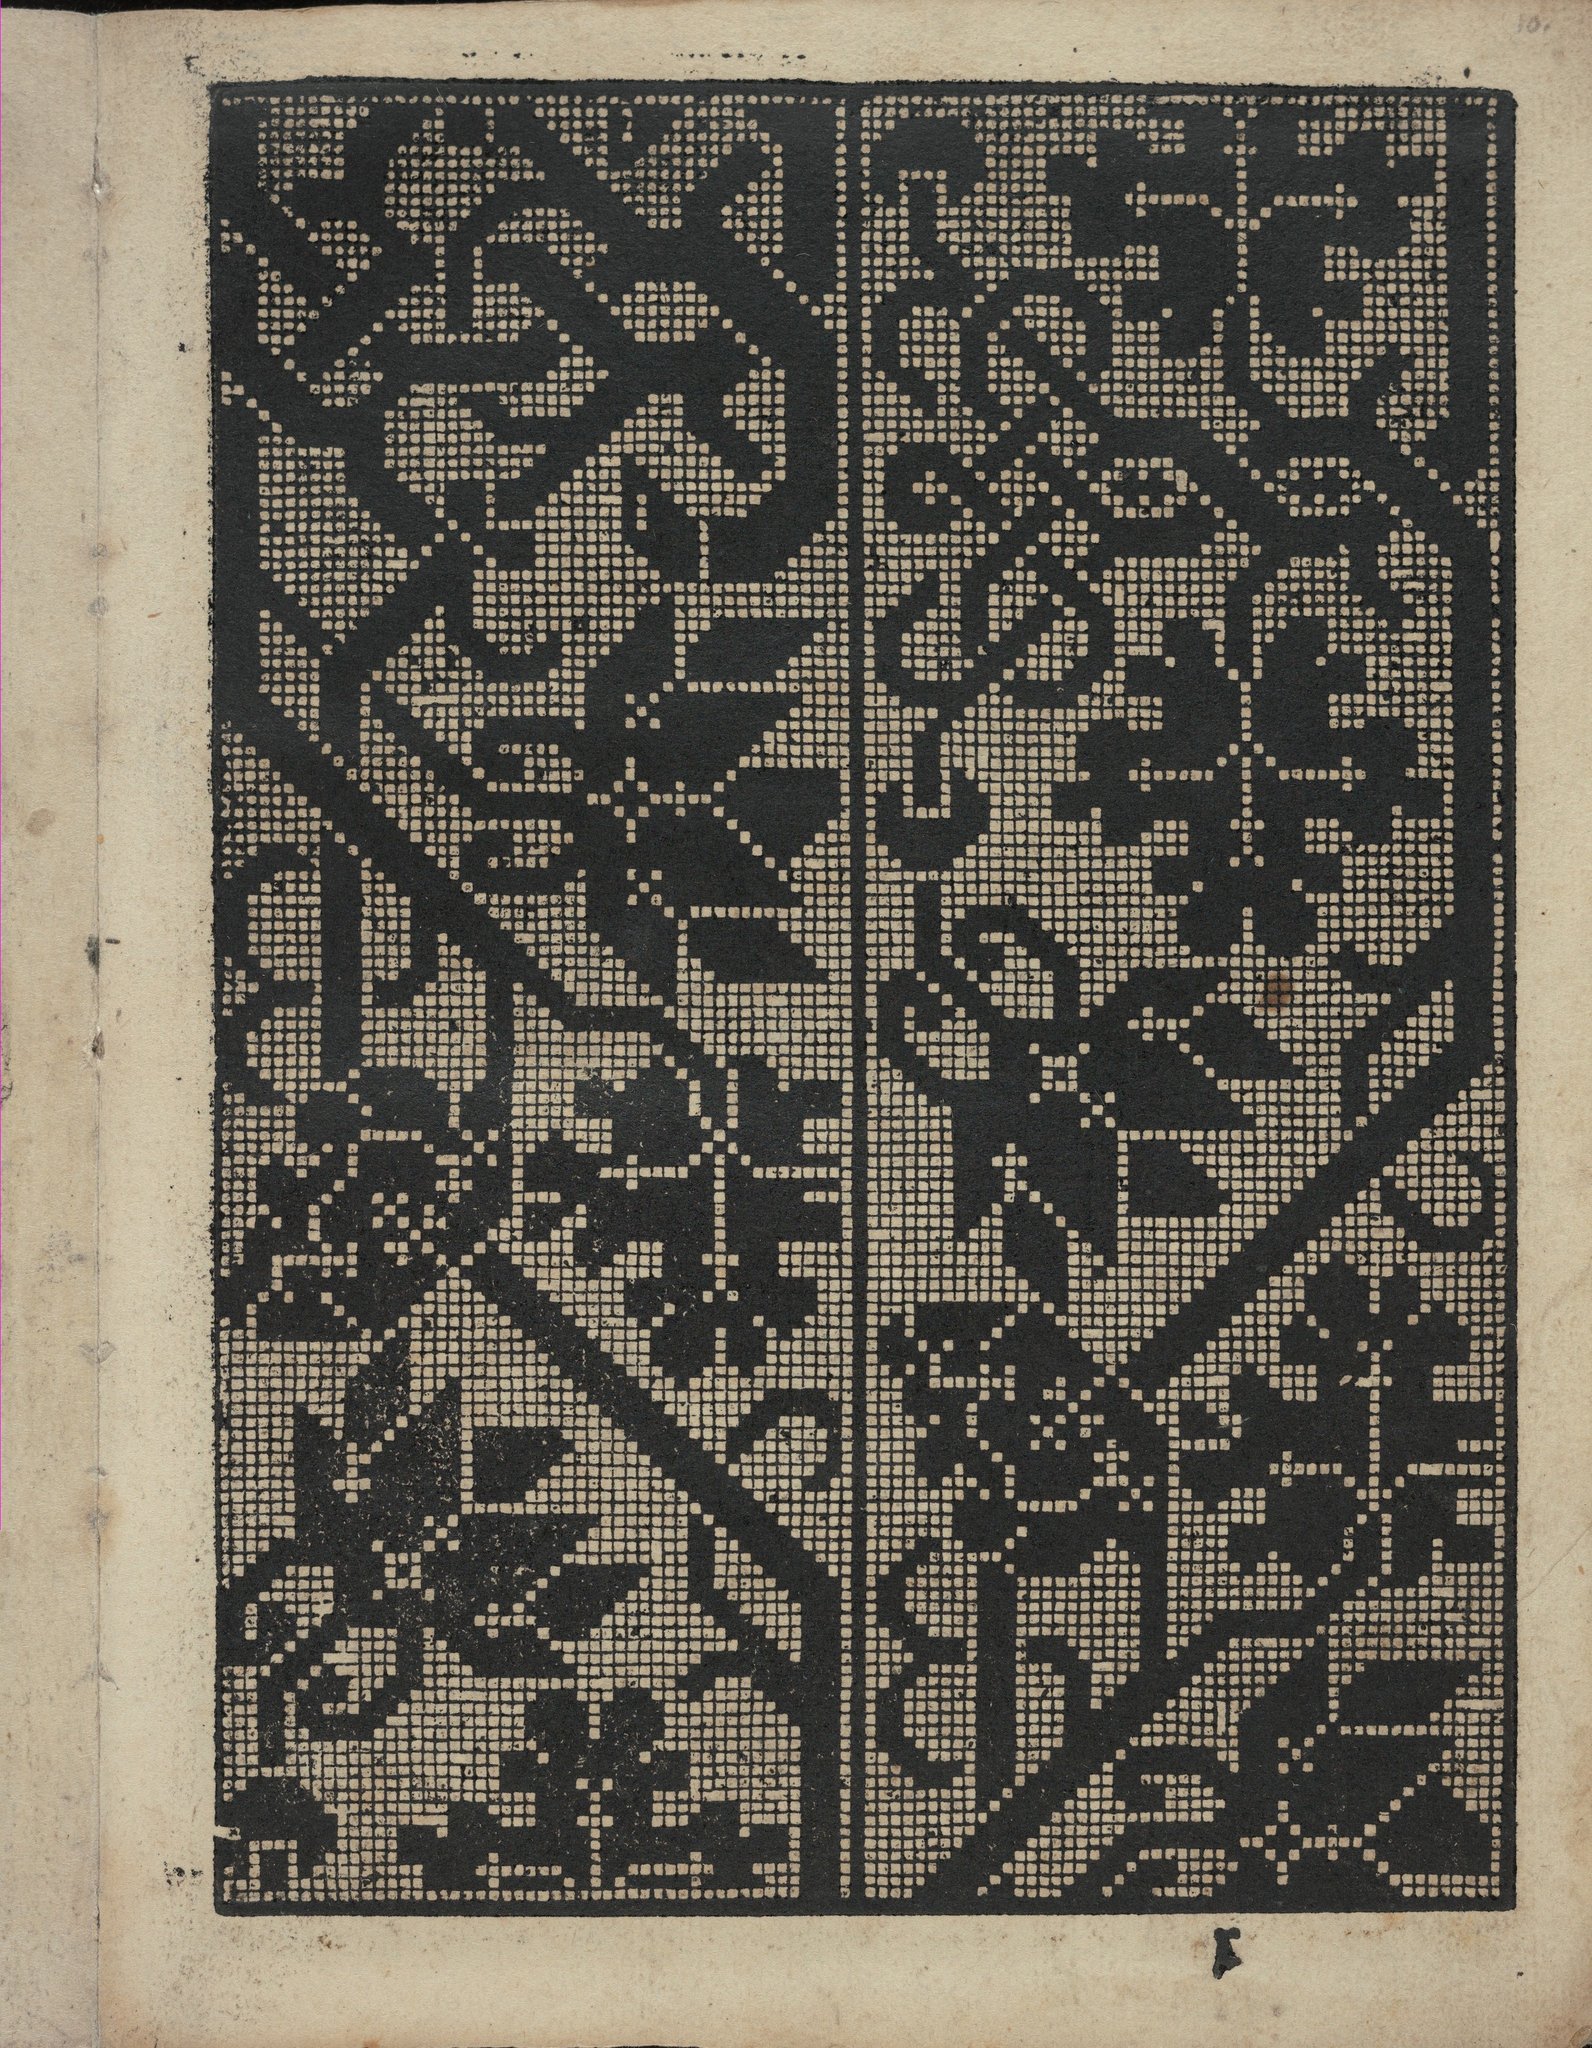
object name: book print ornament architecture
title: Libbretto nouellamete composto per maestro Domenico da Sera...lauorare di ogni sorte di punti, page 10 (recto)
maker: domenico da sera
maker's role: publisher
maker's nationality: french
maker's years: 1500-1599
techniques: woodcut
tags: flowers